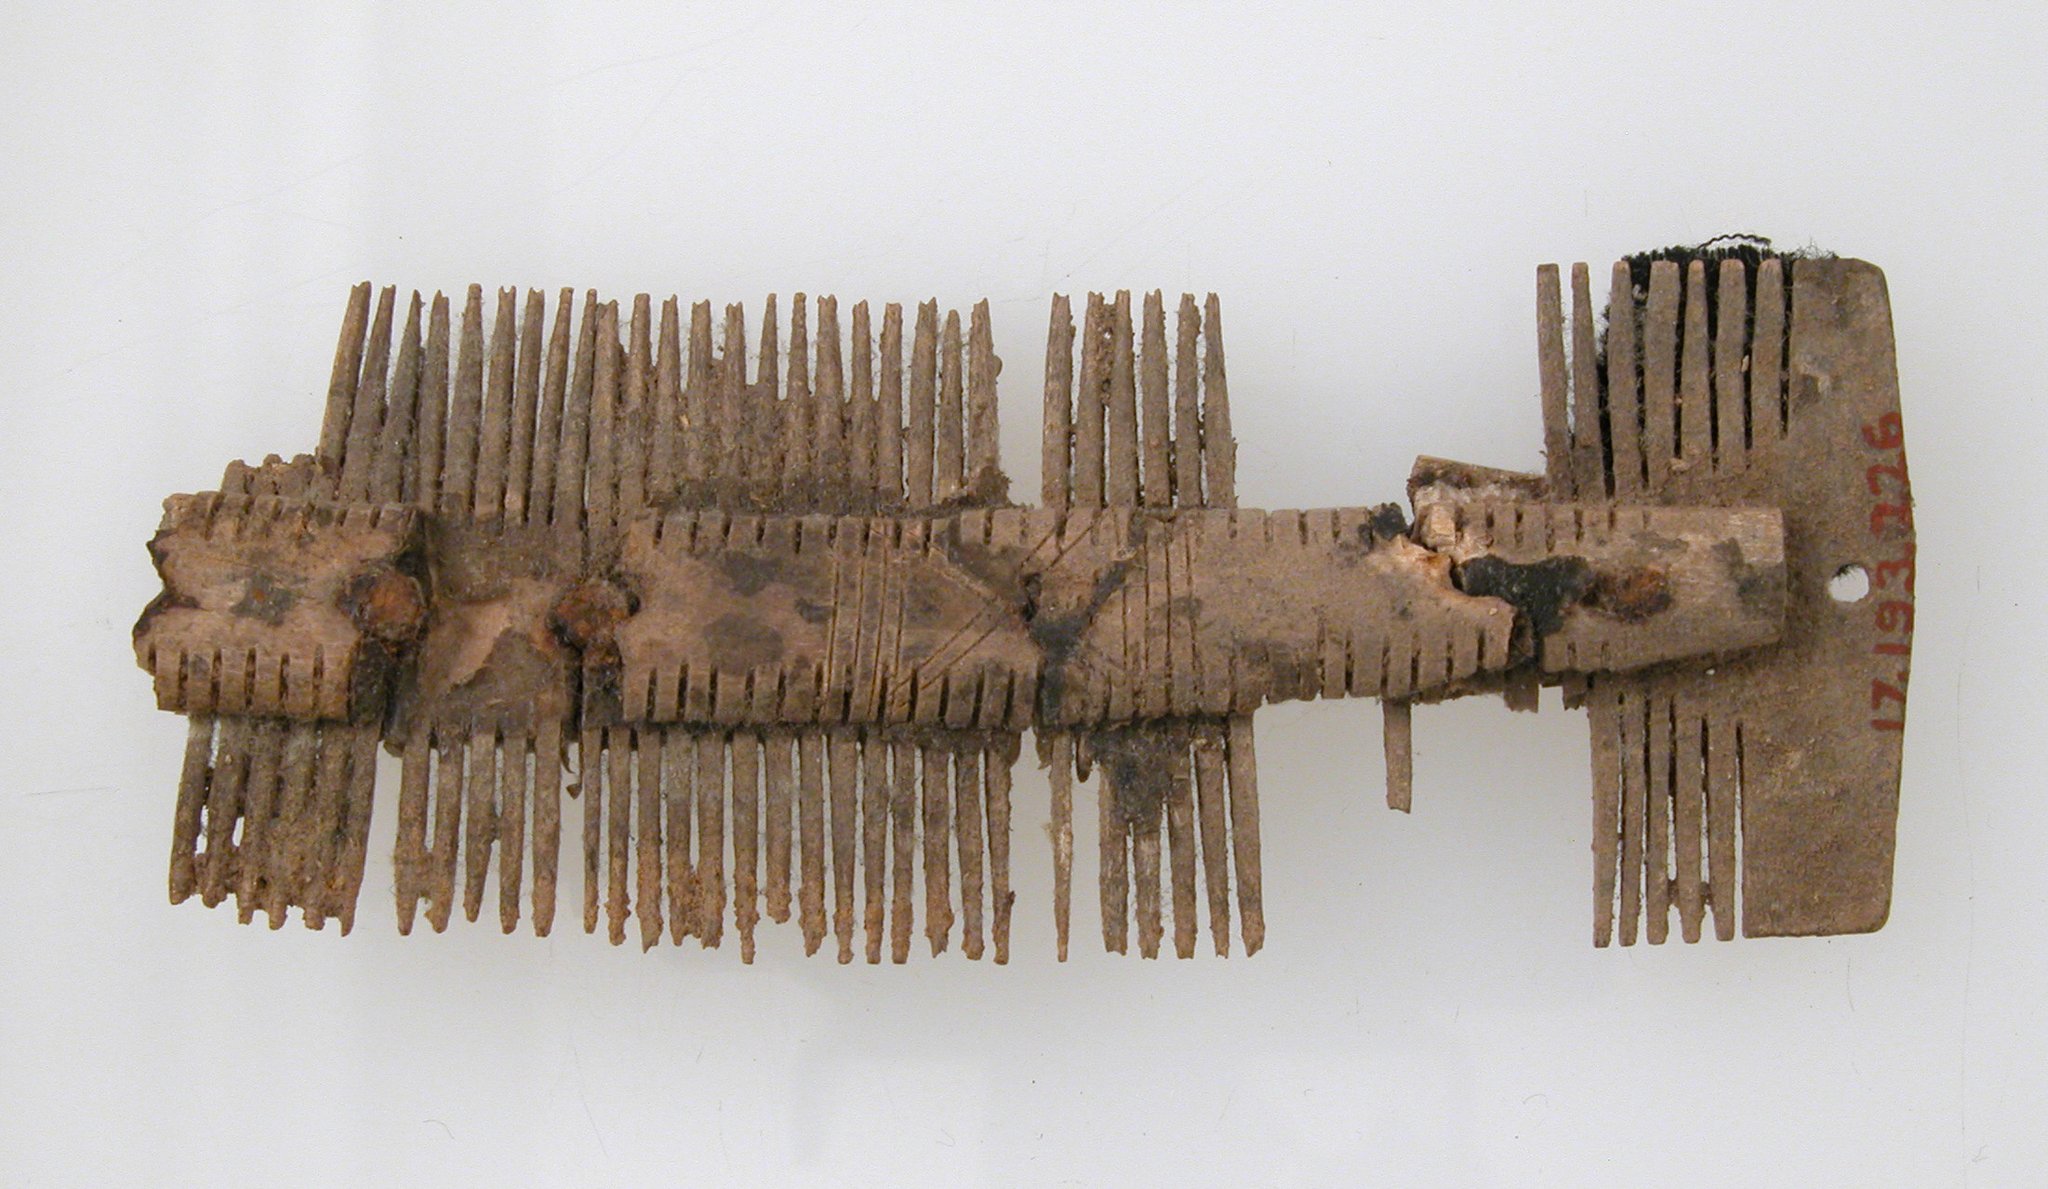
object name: comb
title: Double-Sided Comb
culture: frankish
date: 601-700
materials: bone, iron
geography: germany